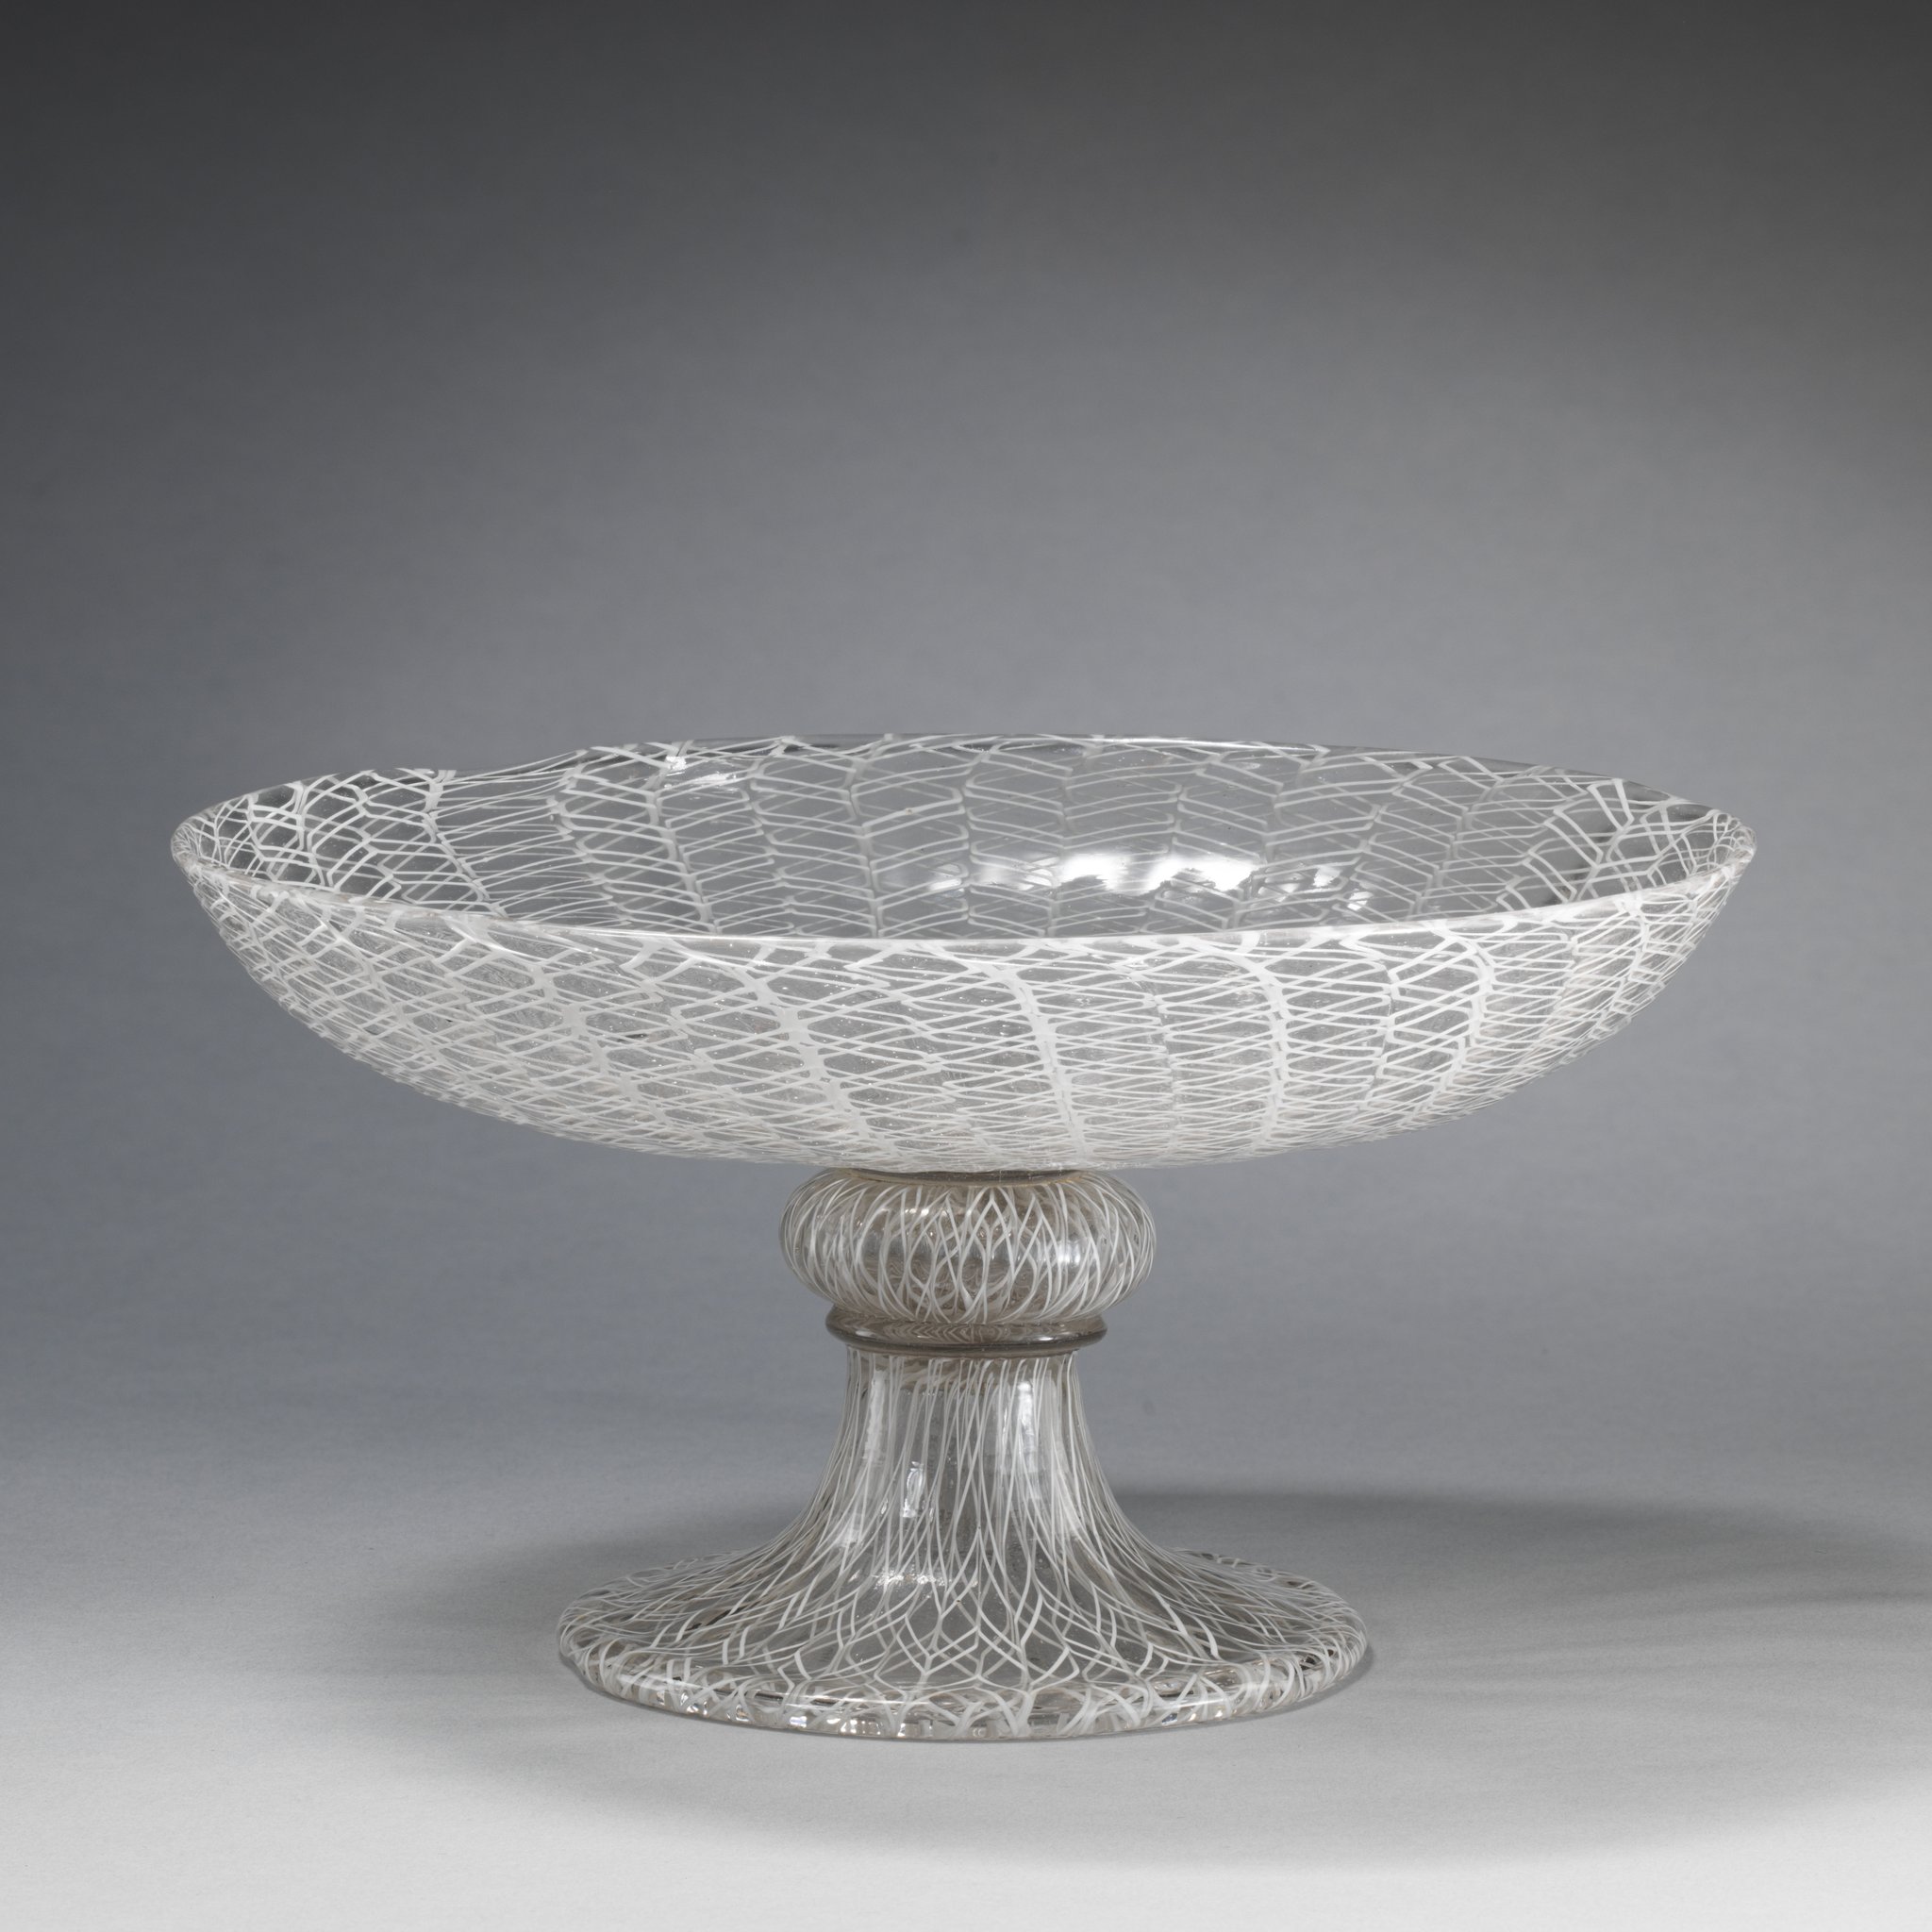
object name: tazza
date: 1701-1800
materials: glass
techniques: glassblowing